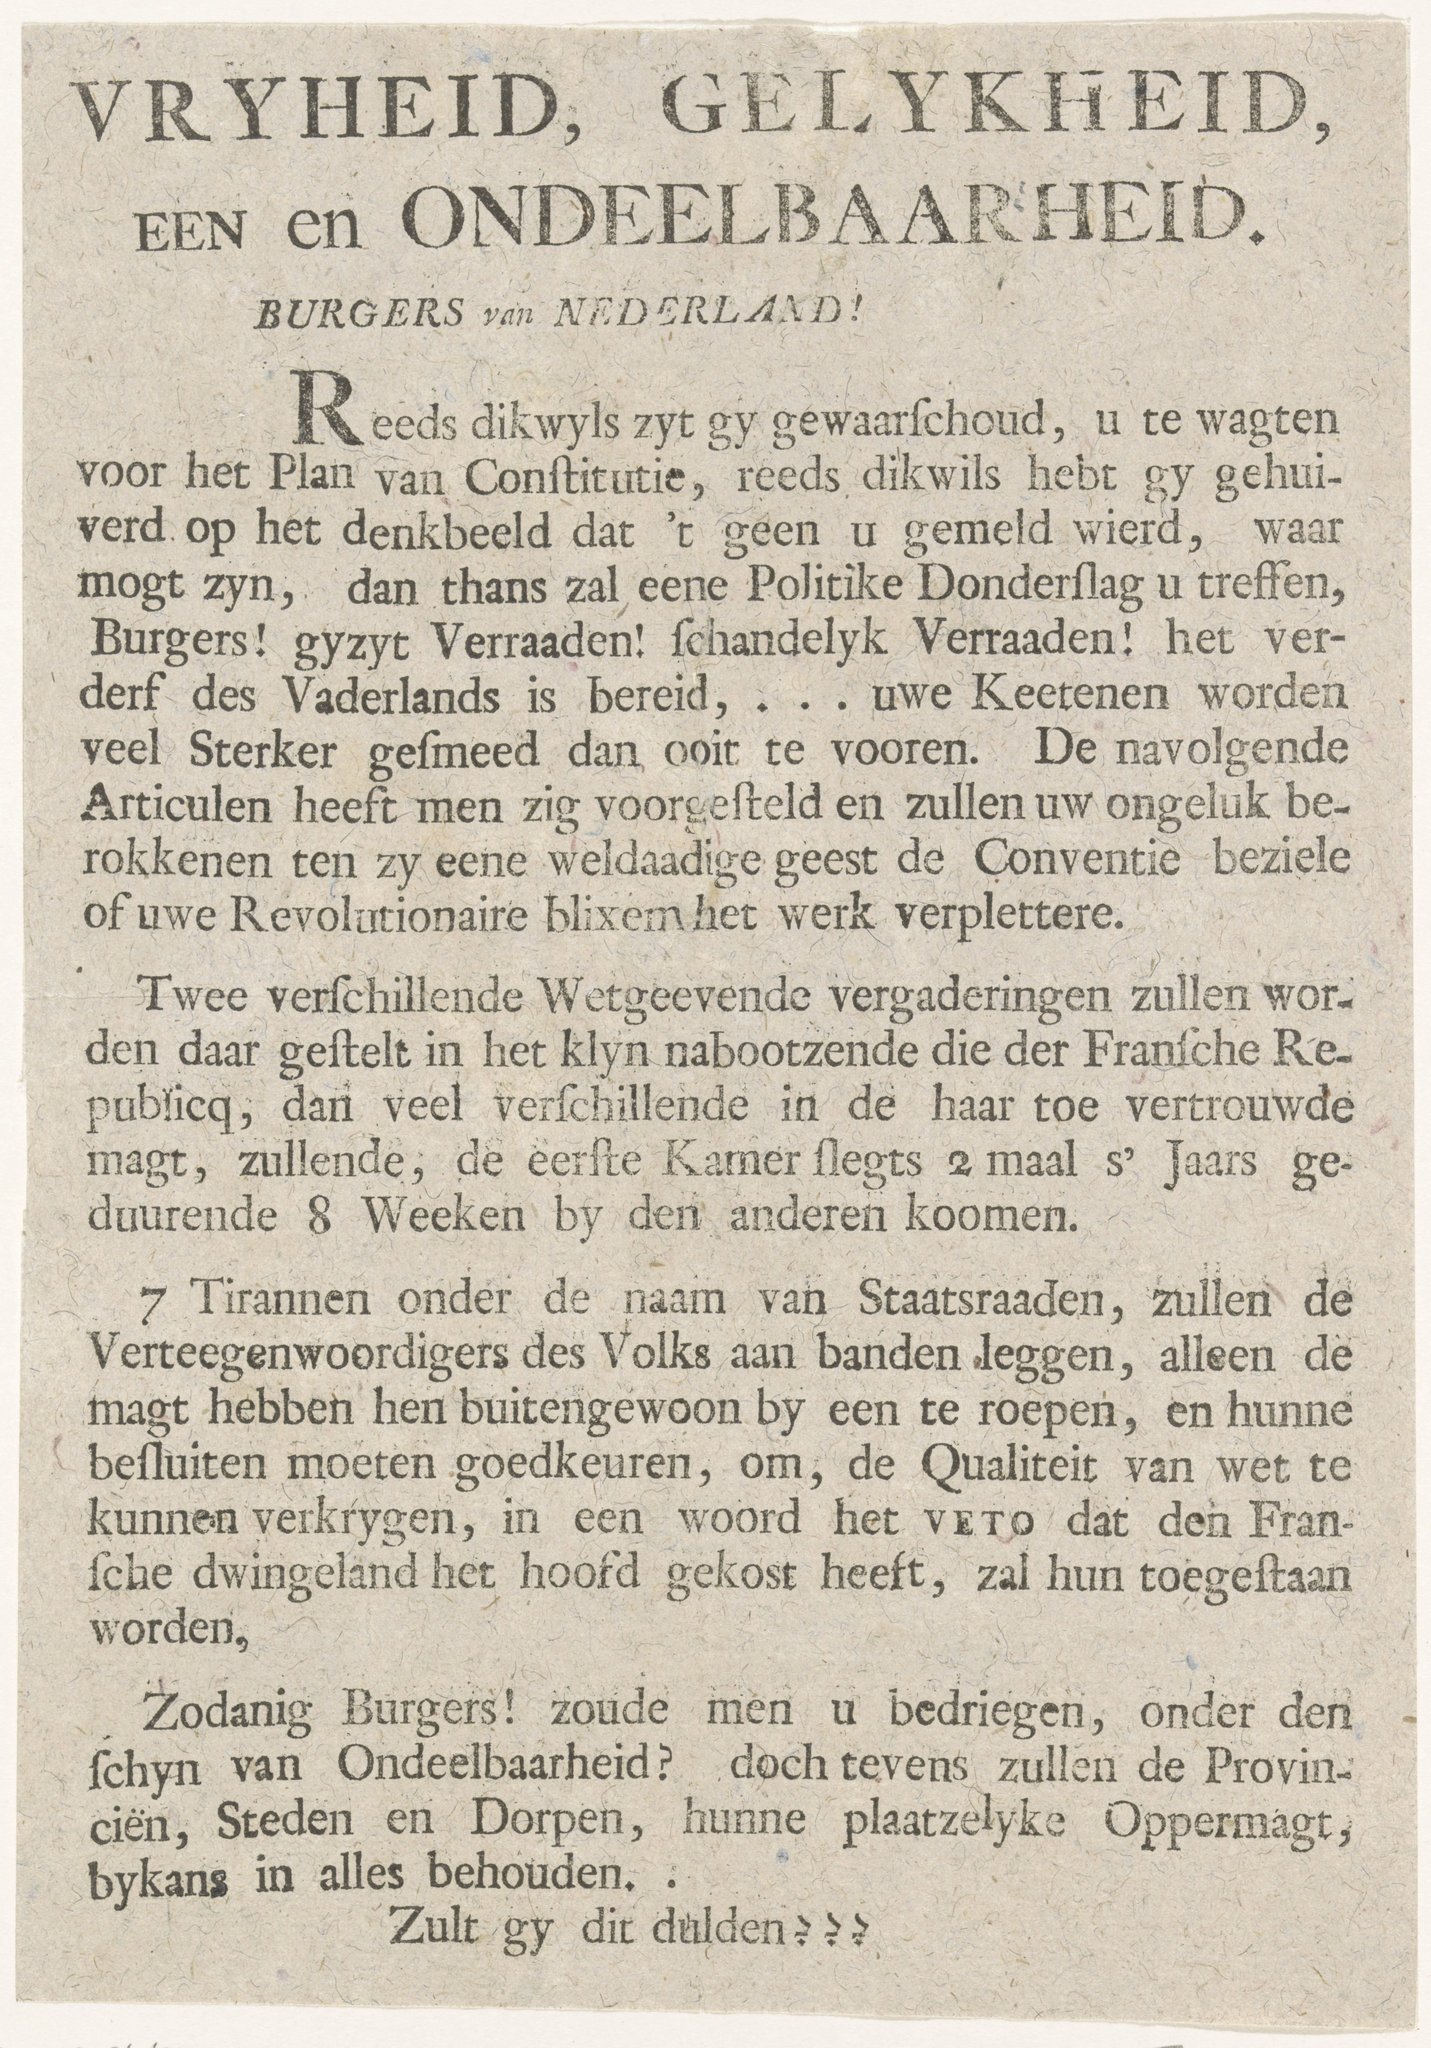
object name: text sheet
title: Waarschuwing tegen de Staatsregeling, 1798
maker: Anonymous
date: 1798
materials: paper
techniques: letterpress printing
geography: netherlands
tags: bataafse revolutie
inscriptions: collector's mark: Lugt 2228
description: Tekstblad met een waarschuwing aan de burgers van Nederland tegen de nieuwe Staatsregeling aangenomen op 19 mei 1798.